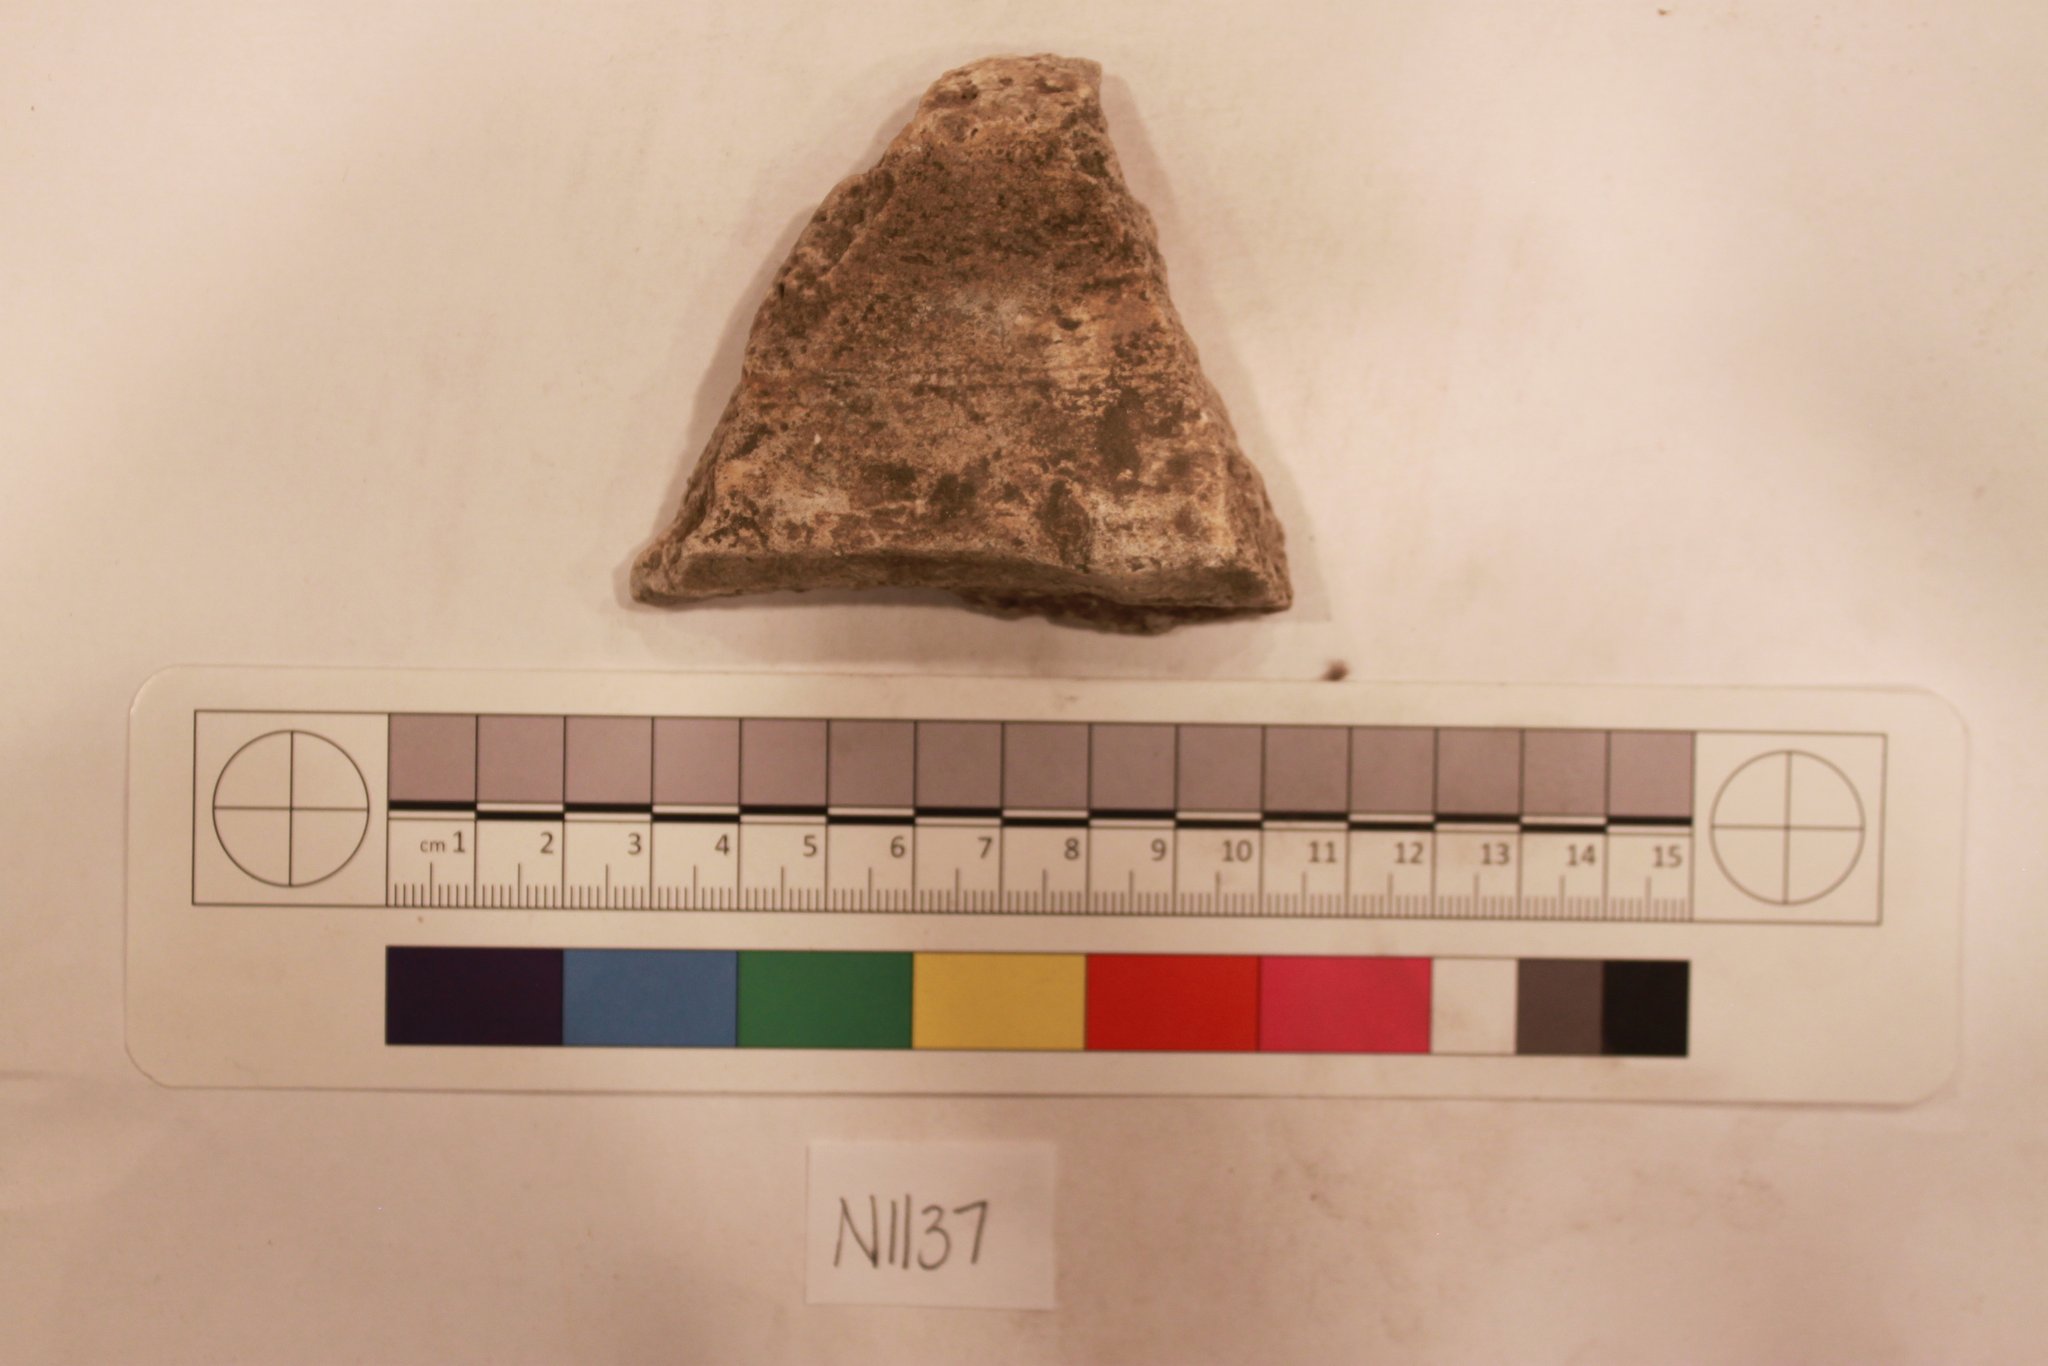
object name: fragment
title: Stucco Fragment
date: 701-1200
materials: plaster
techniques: carving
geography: iran